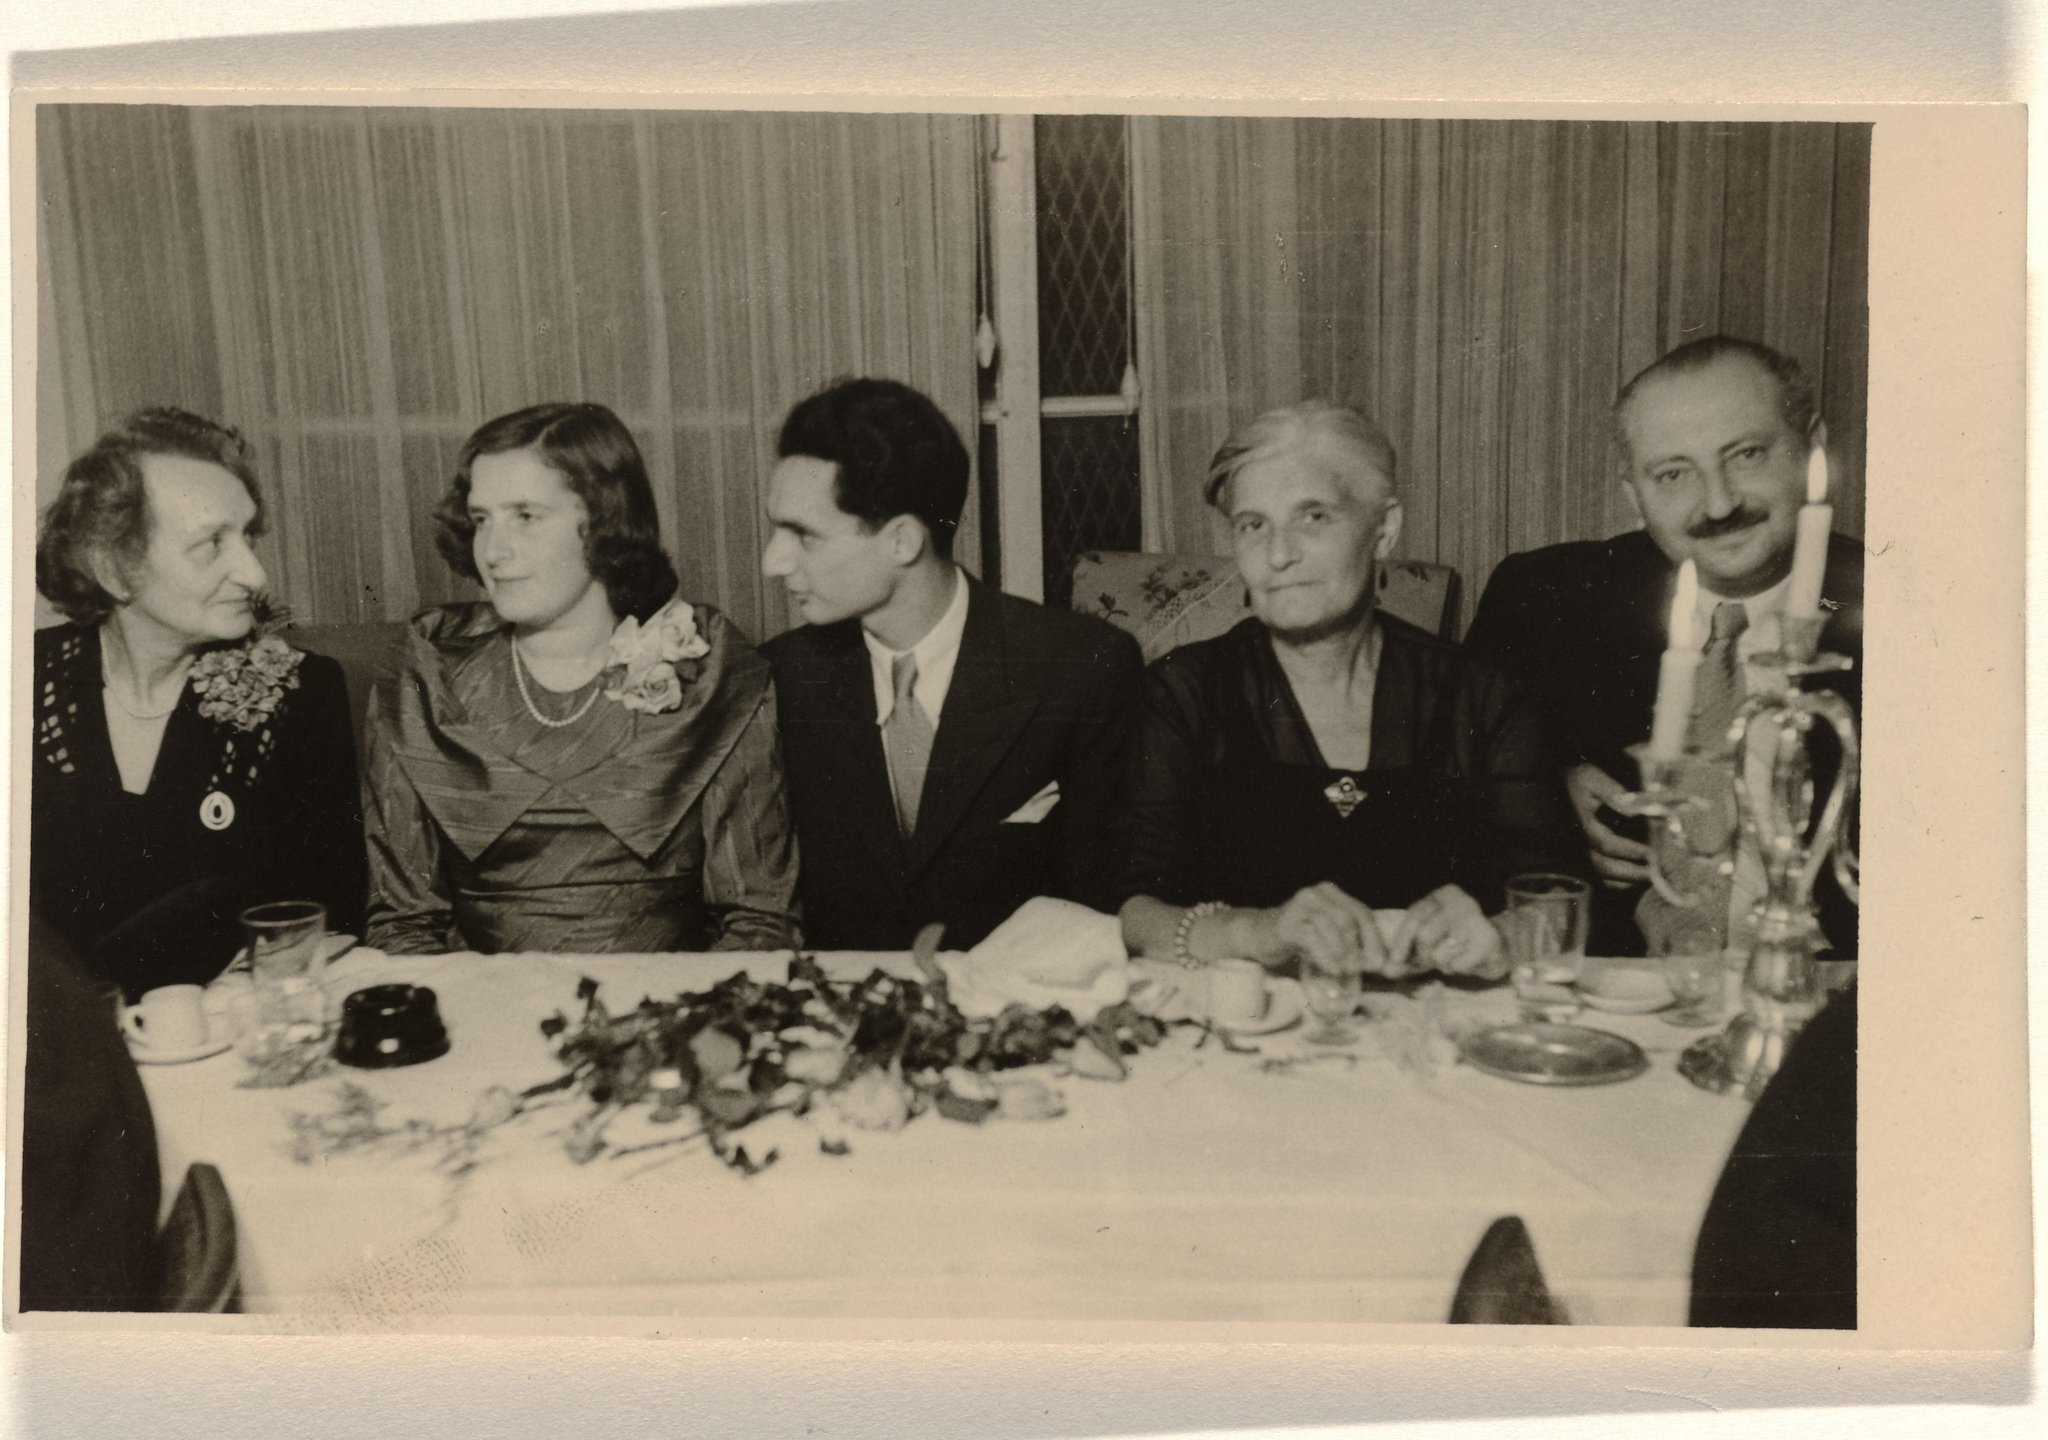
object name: photograph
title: Isabel Wachenheimer en haar tweede echtgenoot Karl-Heinz Arndtheim in sjieke kleding gezeten aan een tafel tijdens een feestelijke aangelegenheid, 1949-1955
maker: Anonymous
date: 1949-1955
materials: photographic support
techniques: gelatin silver print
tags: leiden, isabel wachenheimer-elon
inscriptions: inscription: ‘Party ?/? ? 1950 914/29’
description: Isabel Wachenheimer (tweede van links) en haar tweede echtgenoot Karl-Heinz Arndtheim (midden) in sjieke kleding gezeten aan een tafel tijdens een feestelijke aangelegenheid.